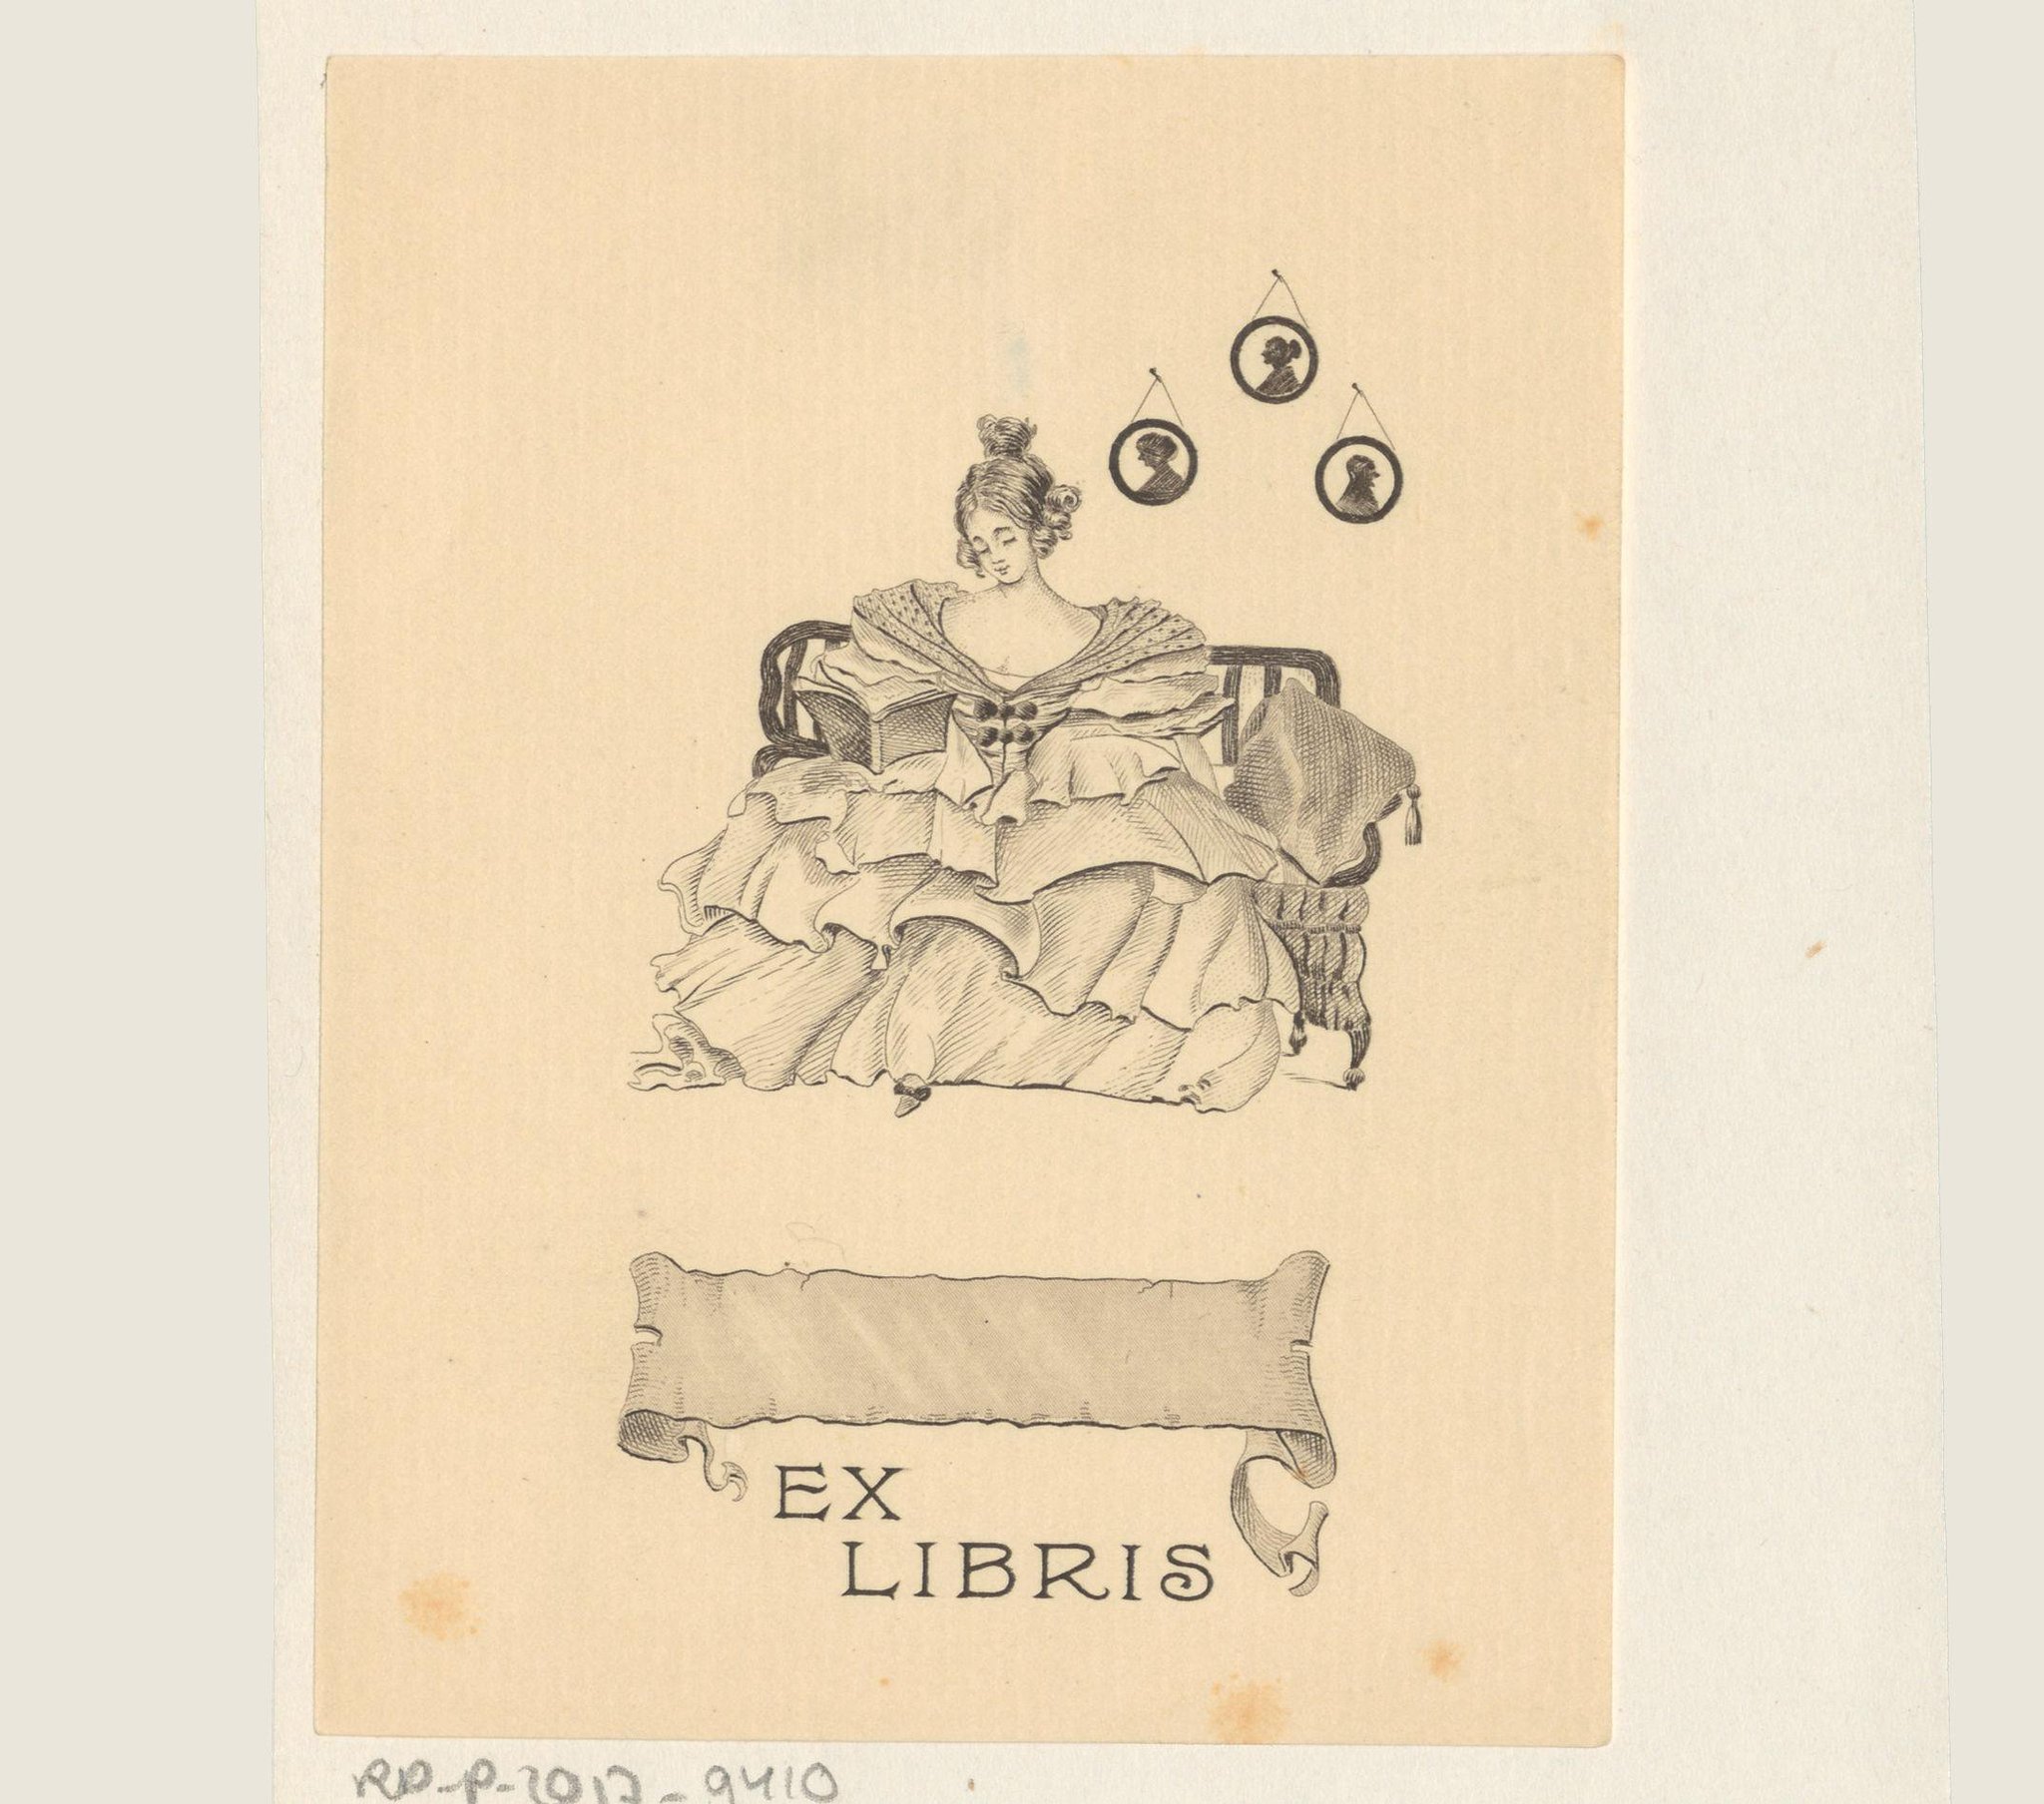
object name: bookplate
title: Ex libris van onbekend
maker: Anonymous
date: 1880-1939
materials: paper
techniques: etching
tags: reading, sitting figure - aa - female human figure, dress, gown: ball gown